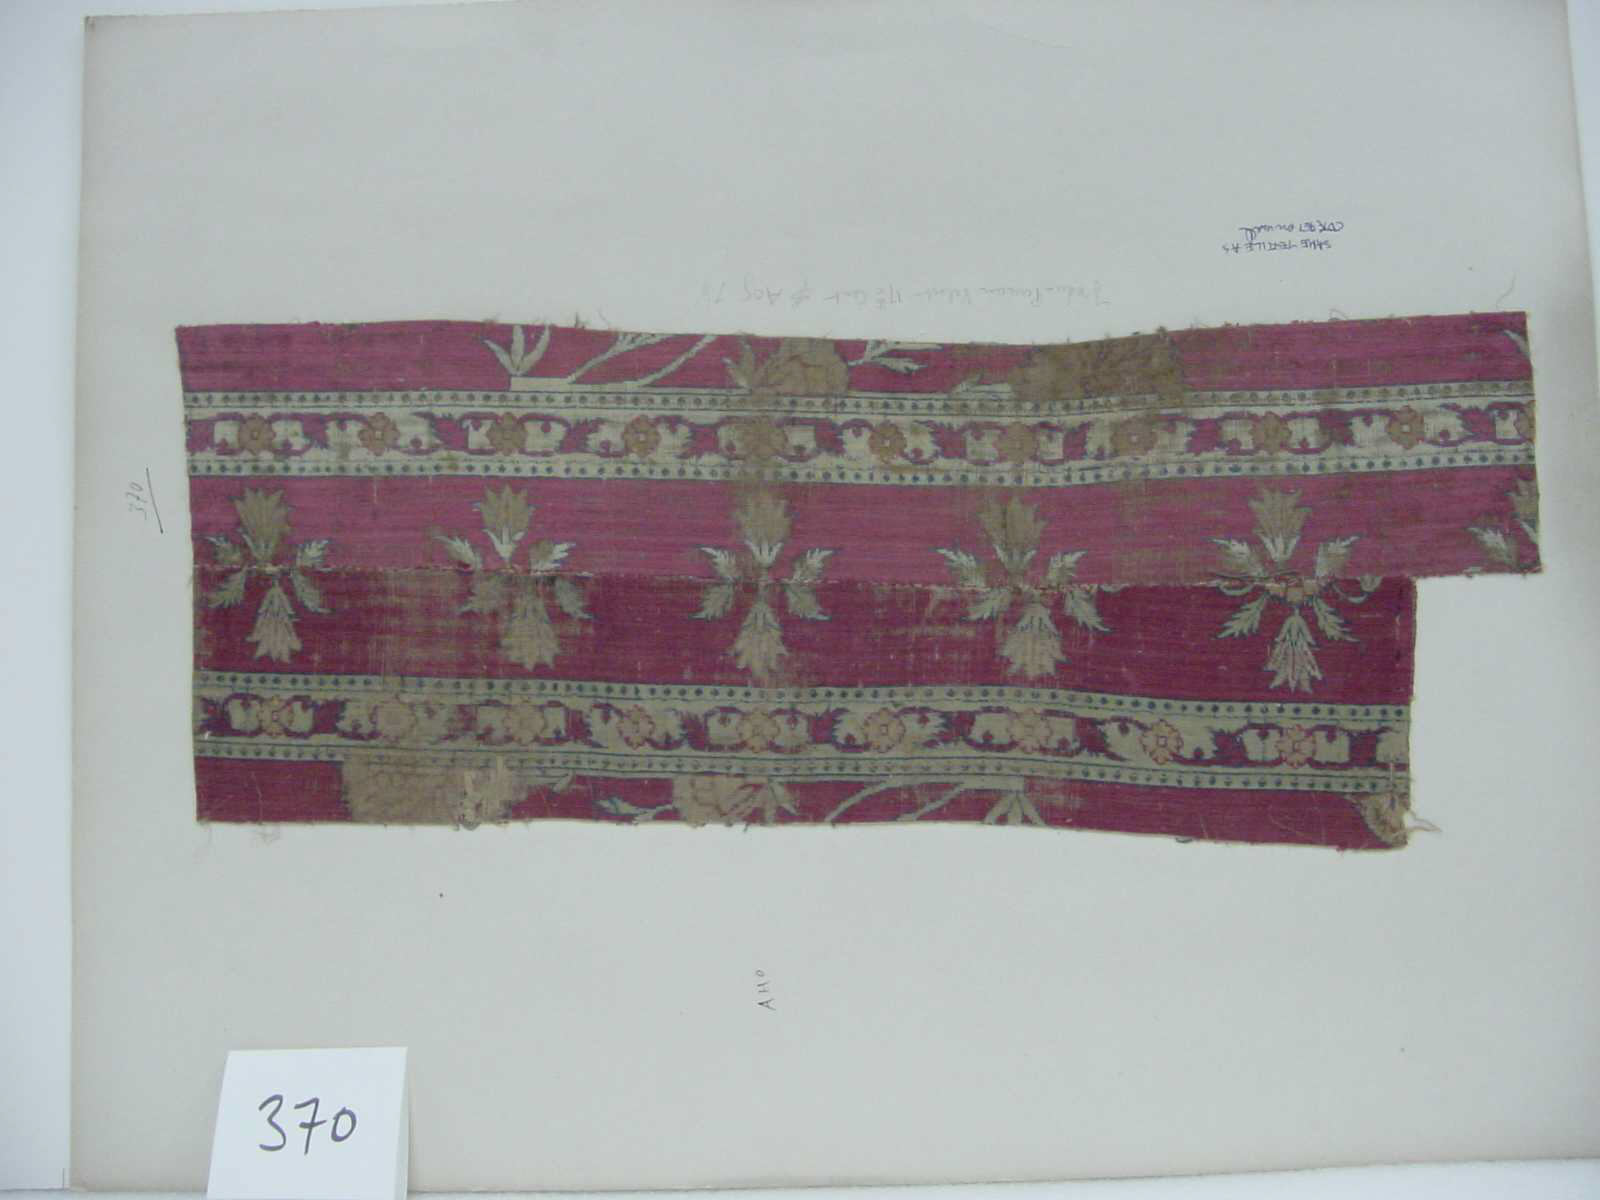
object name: textile fragment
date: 1601-1700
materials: velvet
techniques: cutting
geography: india